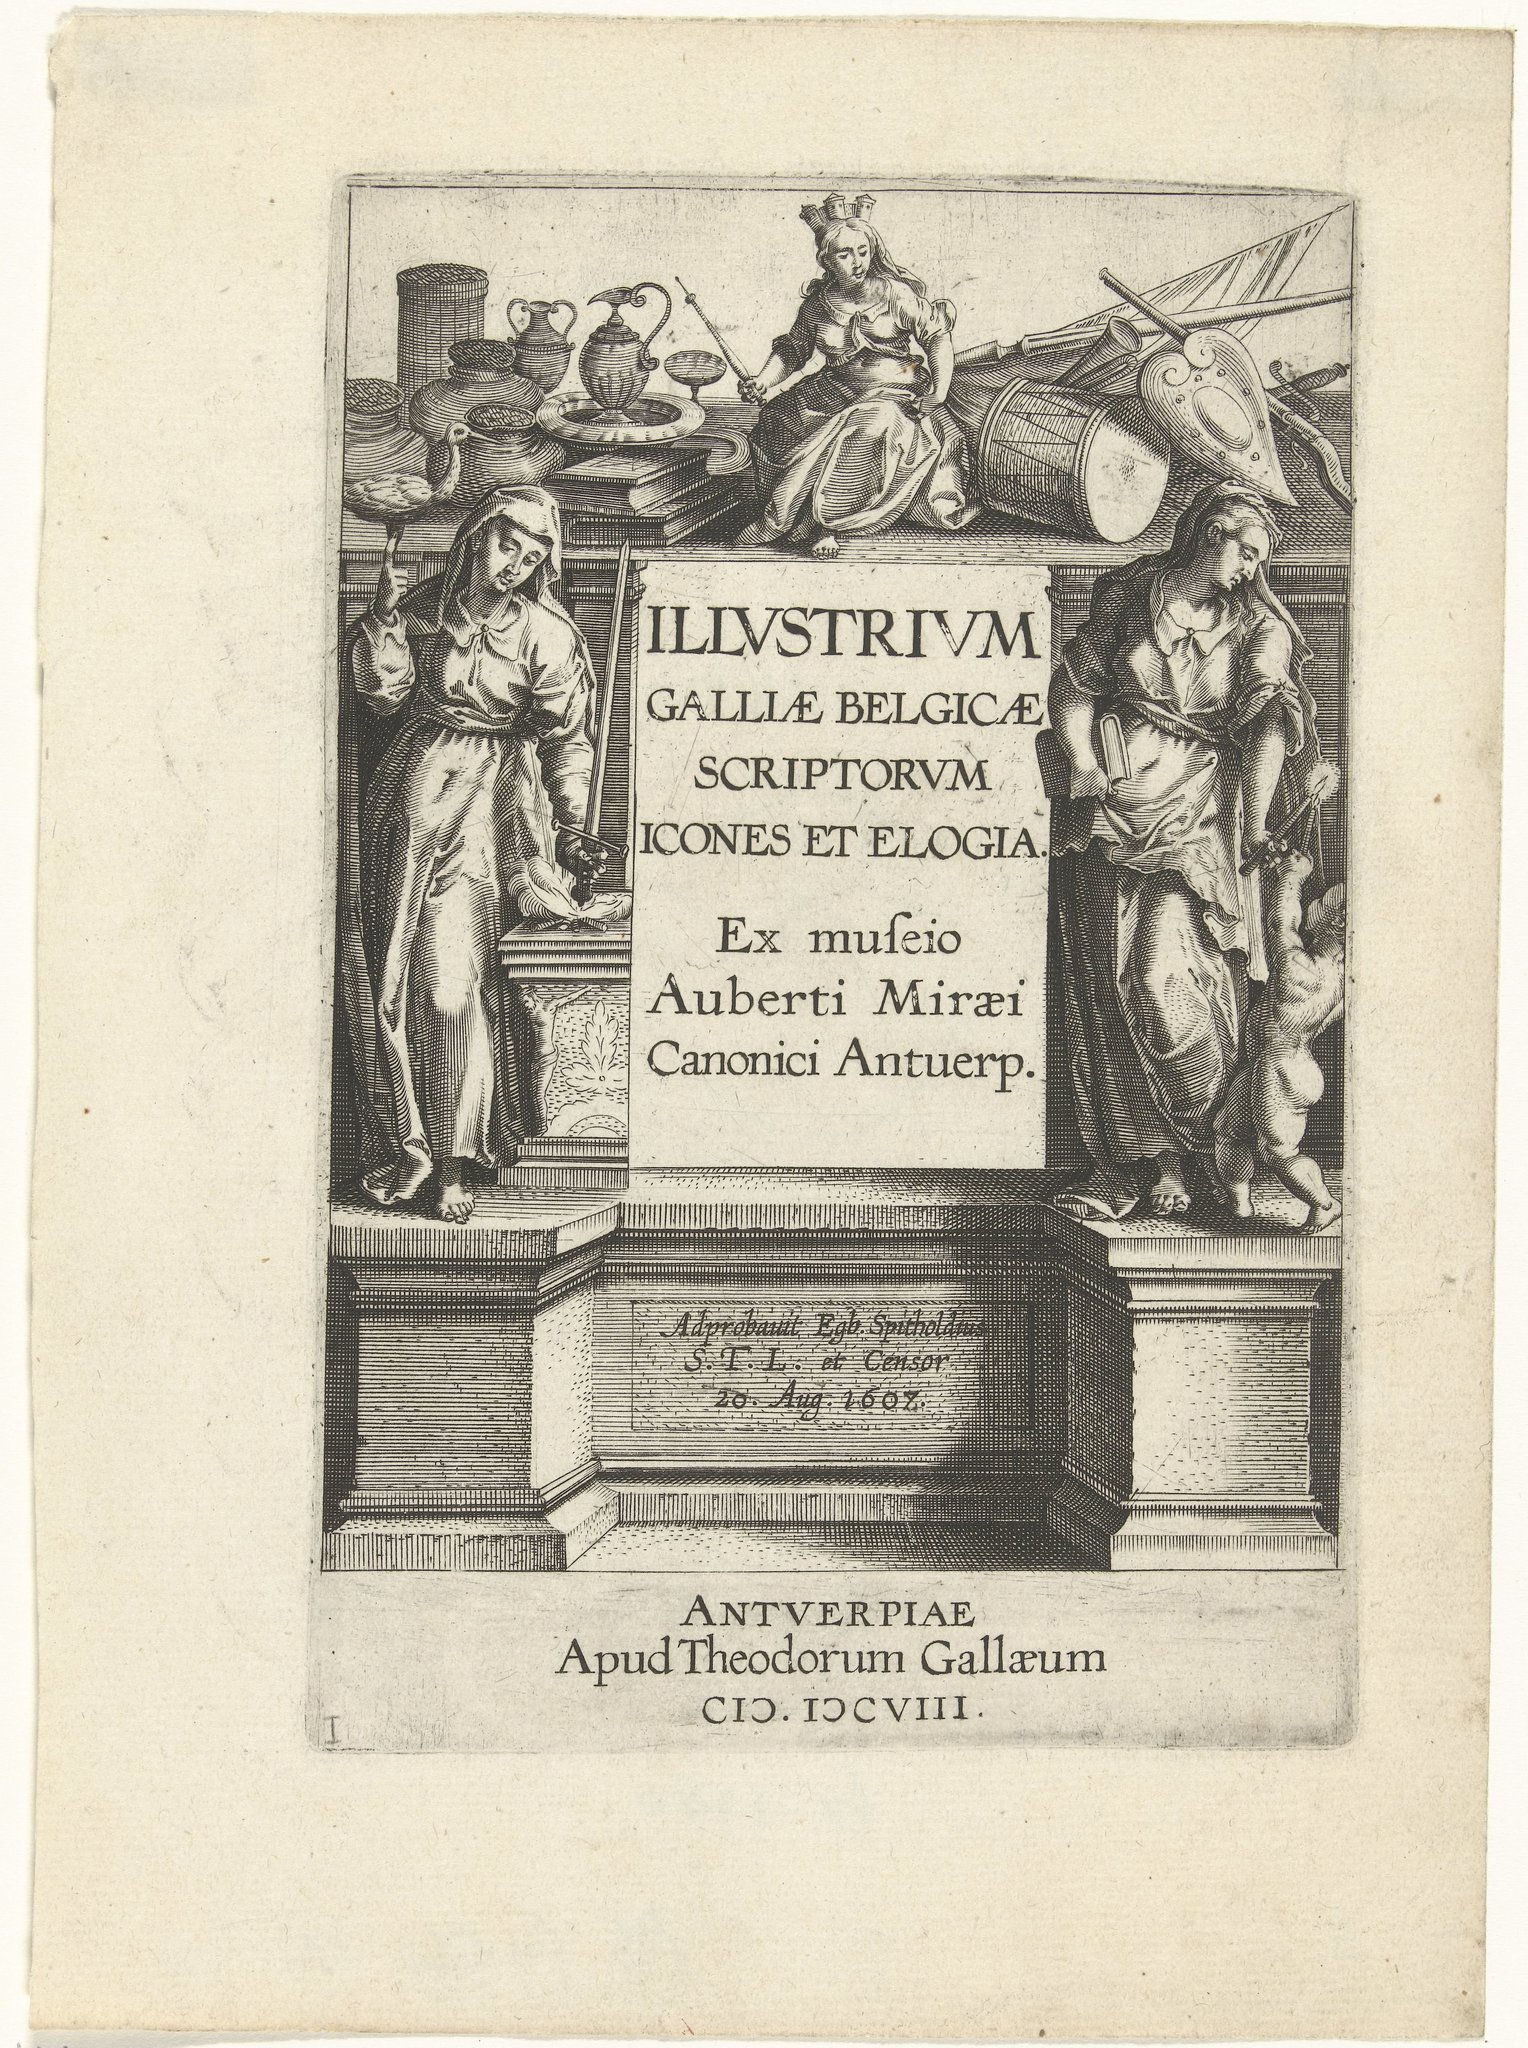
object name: print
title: Titelpagina voor Aubert Le Mire, Illustrium Galliae Belgicae Scrioptorum Icones, 1608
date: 1608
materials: paper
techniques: engraving, letterpress printing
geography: antwerp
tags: justice, 'justitia'; 'giustitia divina' (ripa) ~ one of the four cardinal virtues, personification of a city, town-patron(ess), hope, 'spes'; 'speranza divina e certa' (ripa) ~ one of the three theological virtues - mm - virtues triumphant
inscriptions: collector's mark: Lugt 2228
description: Centraal de titel van het boek, geflankeerd door Hoop en Rechtvaardigheid. Boven de titel de personificatie van Antwerpen. De prent is de titelpagina van Aubert Le Mire, Illustrium Galliae Belgicae Scrioptorum Icones, 1608.